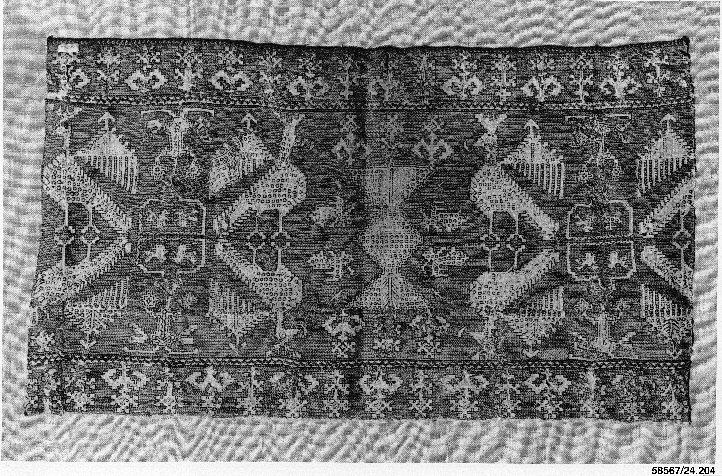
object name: cover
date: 1601-1700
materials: silk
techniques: embroidery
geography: morocco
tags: birds